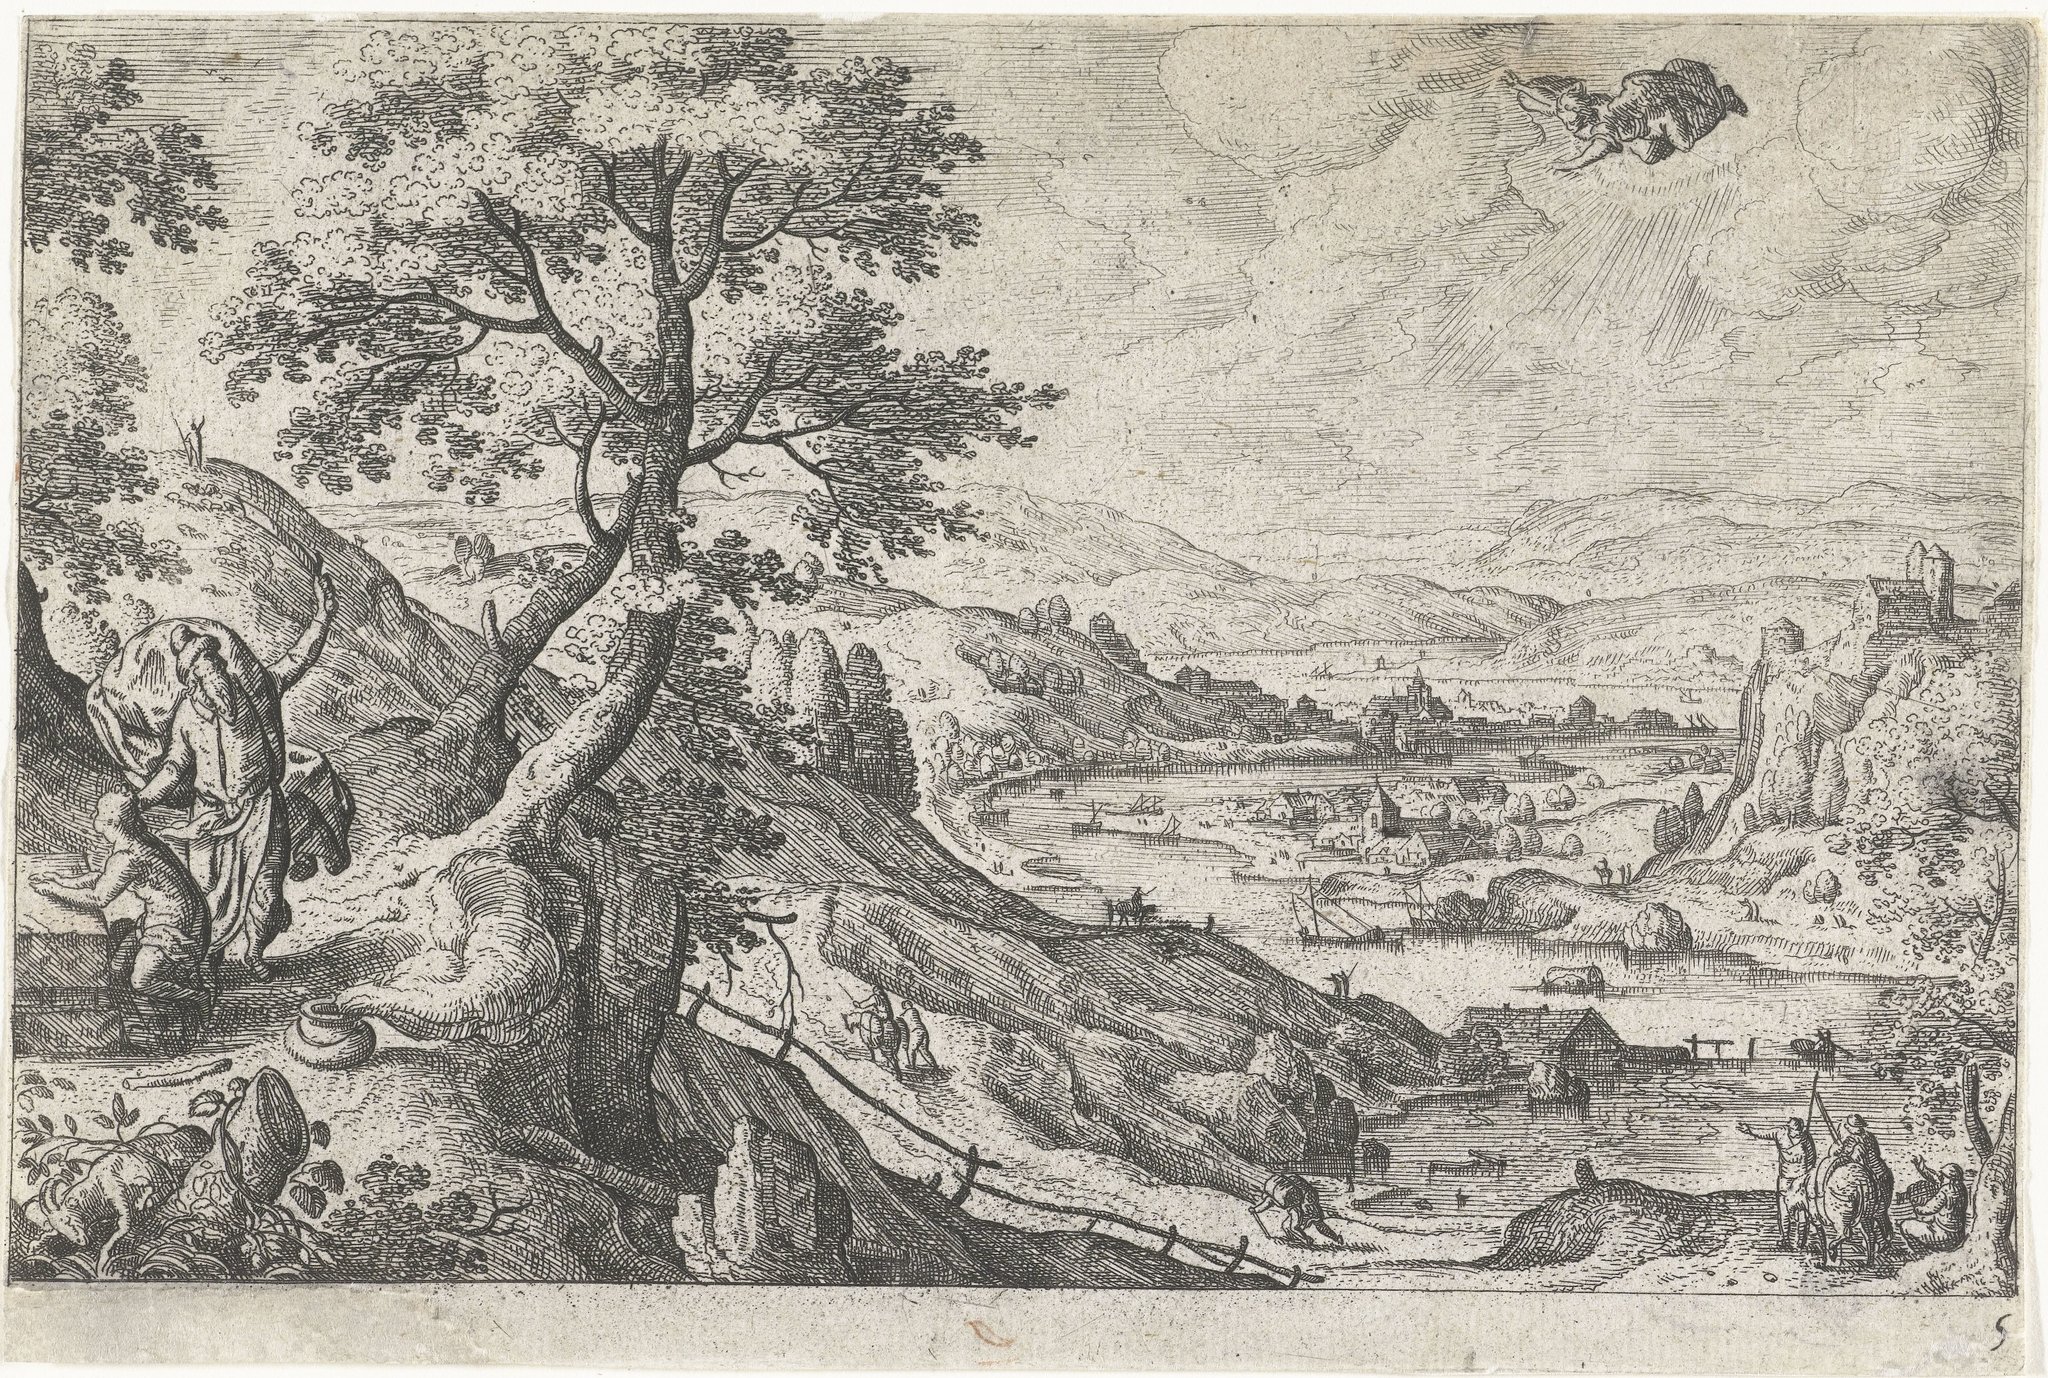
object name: print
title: Landschappen met mythologische en bijbelse voorstellingen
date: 1550-1650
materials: paper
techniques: etching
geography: southern netherlands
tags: when abraham has his hand raised to kill isaac, an angel restrains abraham's hand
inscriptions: collector's mark: Lugt 2228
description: Abraham staat op het punt om zijn zoon Isaak te offeren. Een engel houdt hem tegen en Abraham offert in plaats van Isaak een ram die zich links voor in een struik heeft verstrikt.